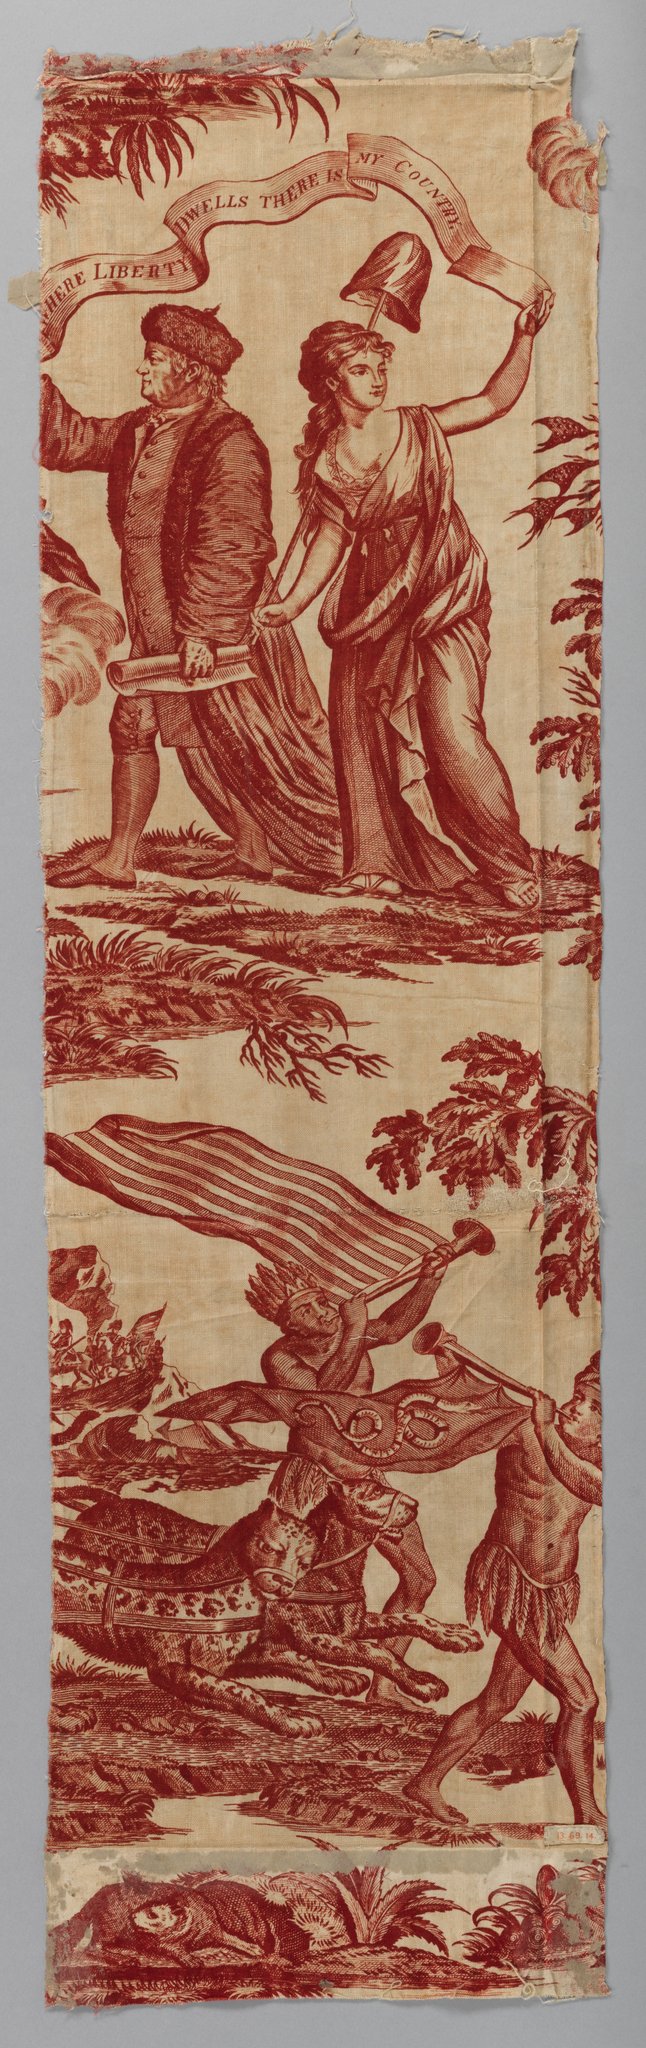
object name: piece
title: Apotheosis of Franklin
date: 1790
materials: cotton, linen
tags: men,women,leopards,snakes,flags